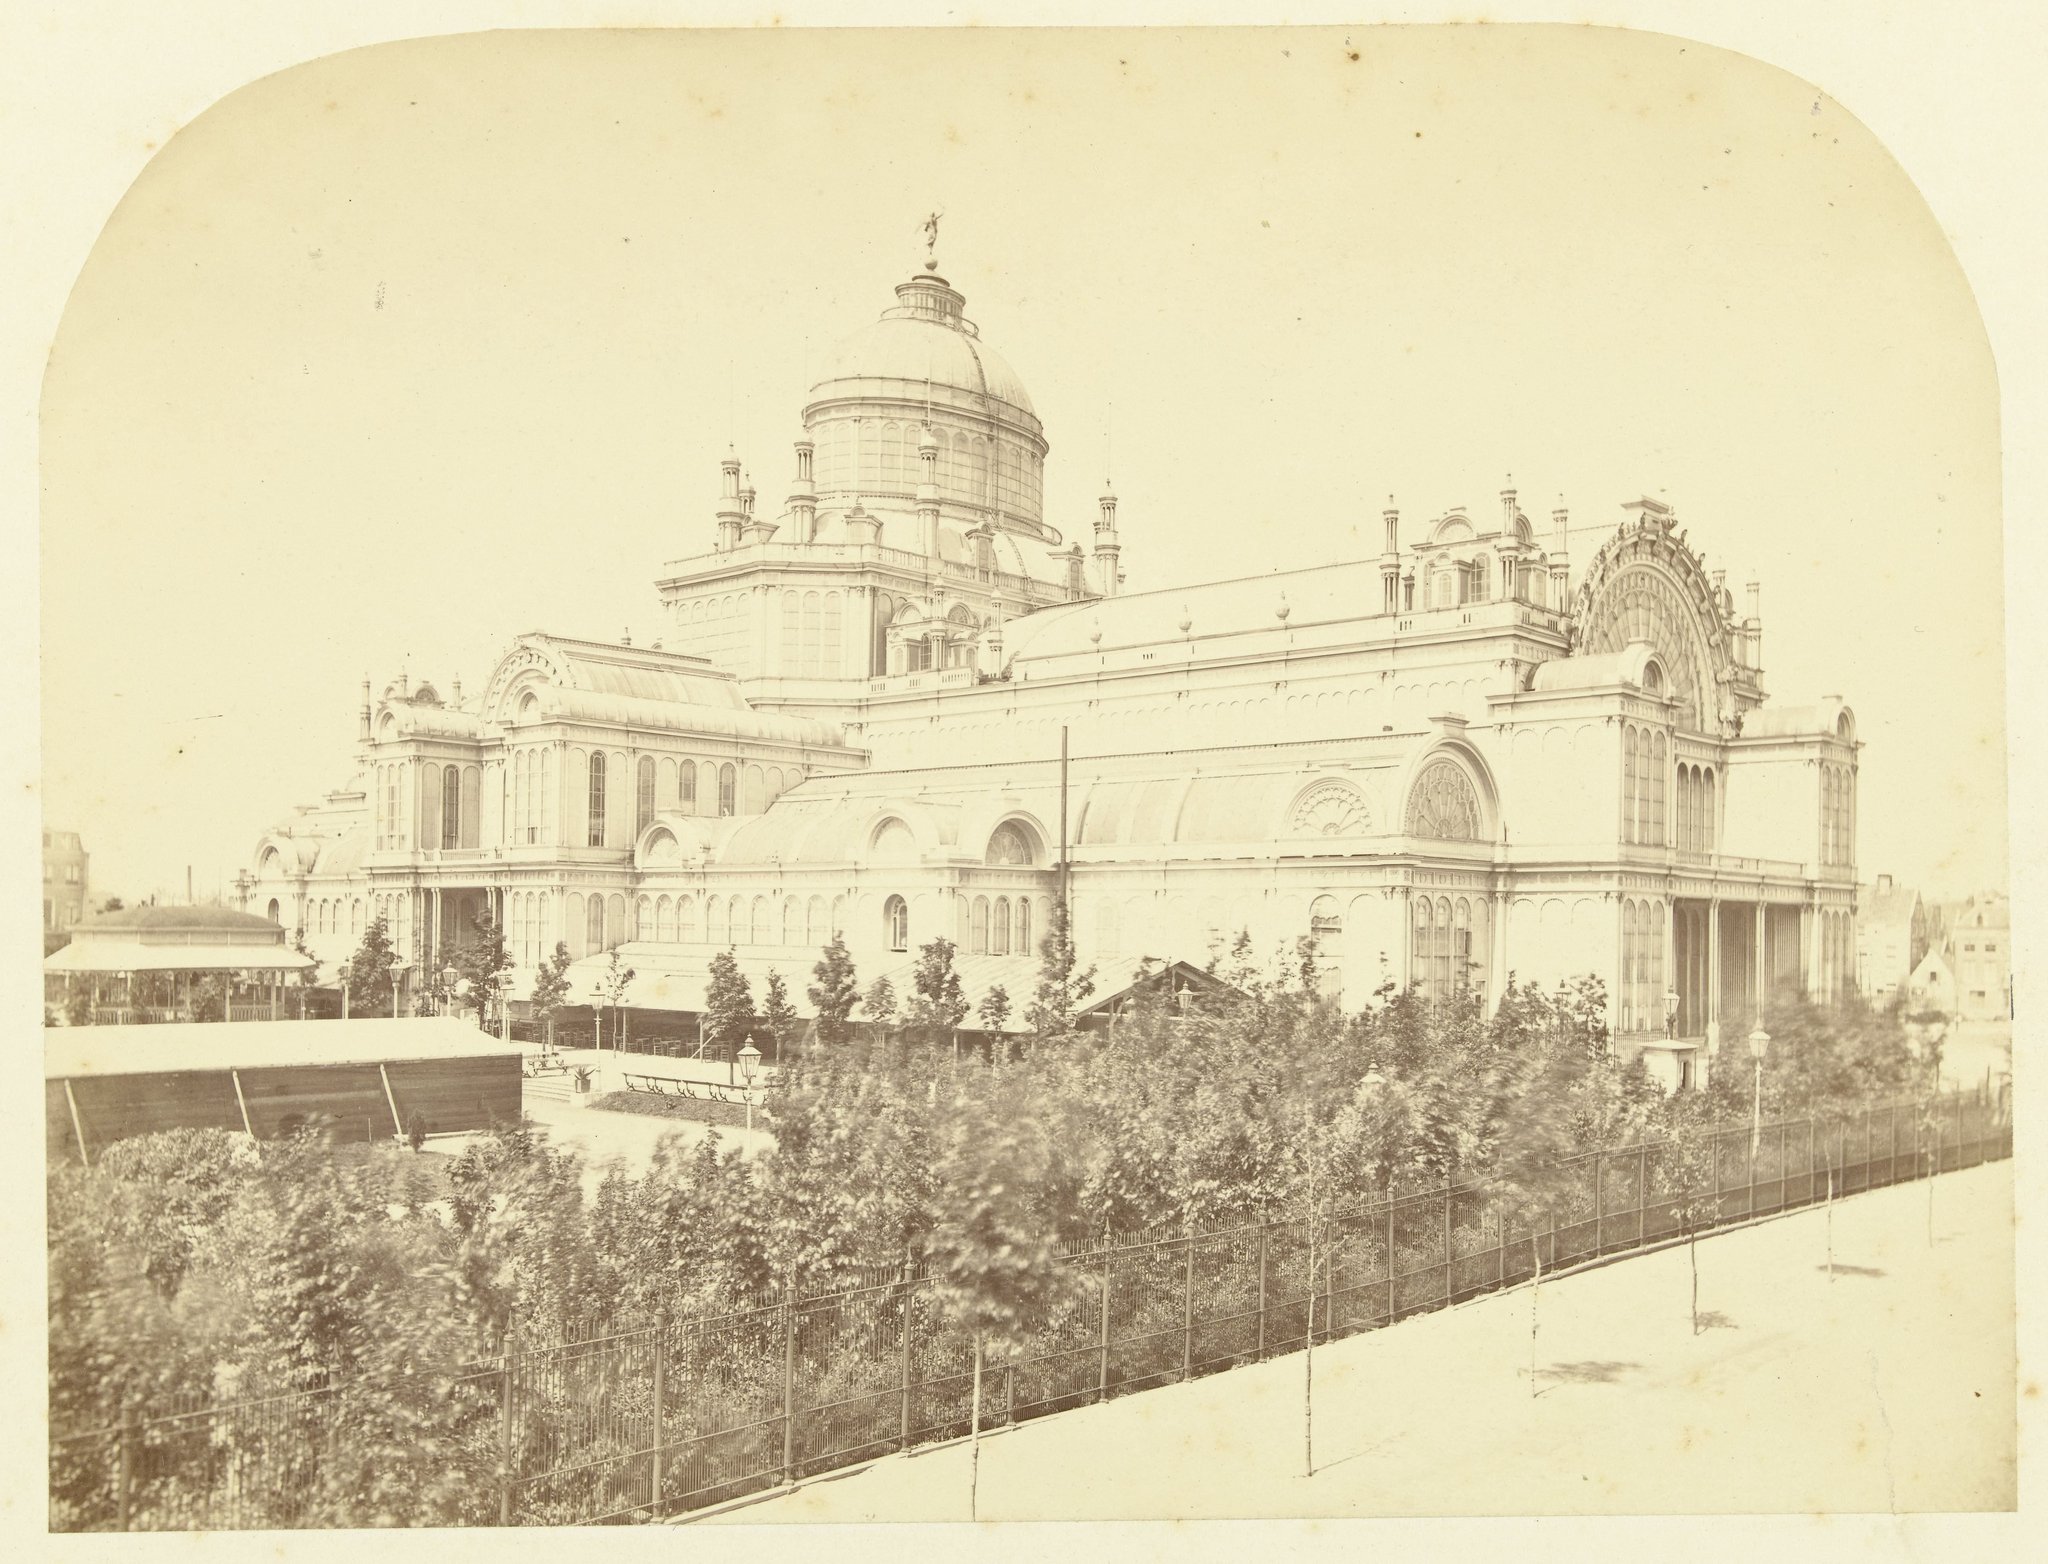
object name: photograph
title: Paleis voor Volksvlijt in Amsterdam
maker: Anonymous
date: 1865-1870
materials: paper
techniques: albumen print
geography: netherlands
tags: temporary exhibition, 'salon'